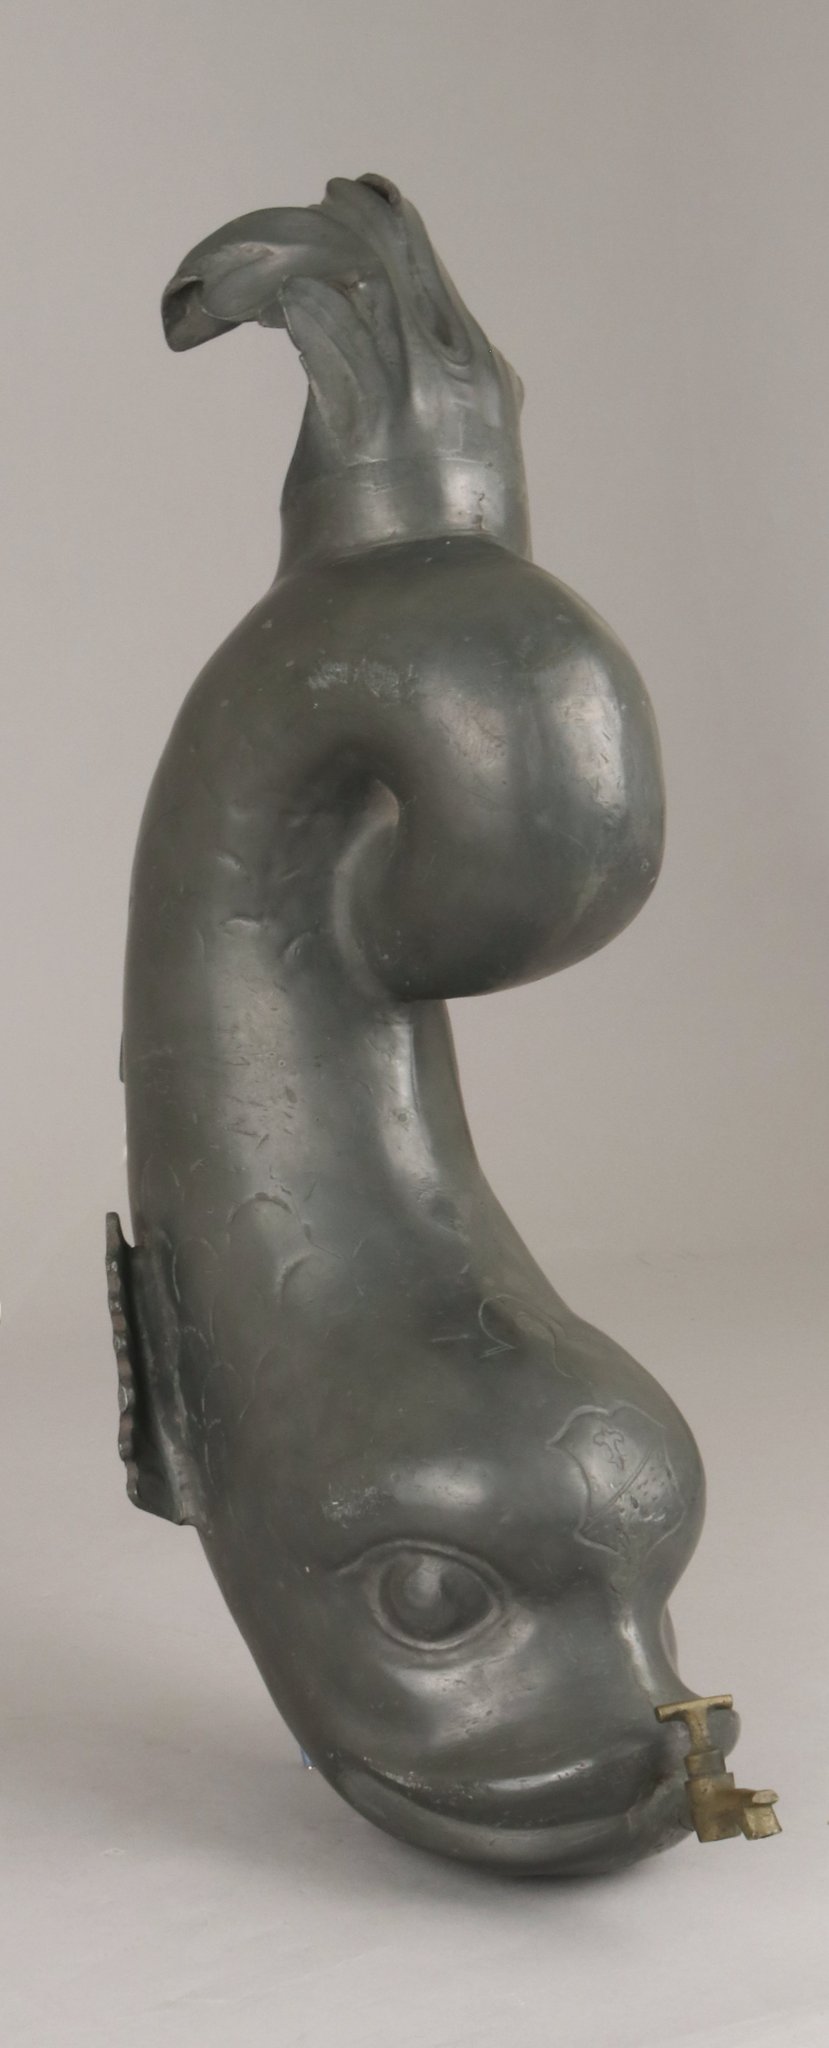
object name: lavatory or portable cistern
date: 1701-1900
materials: pewter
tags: dolphins